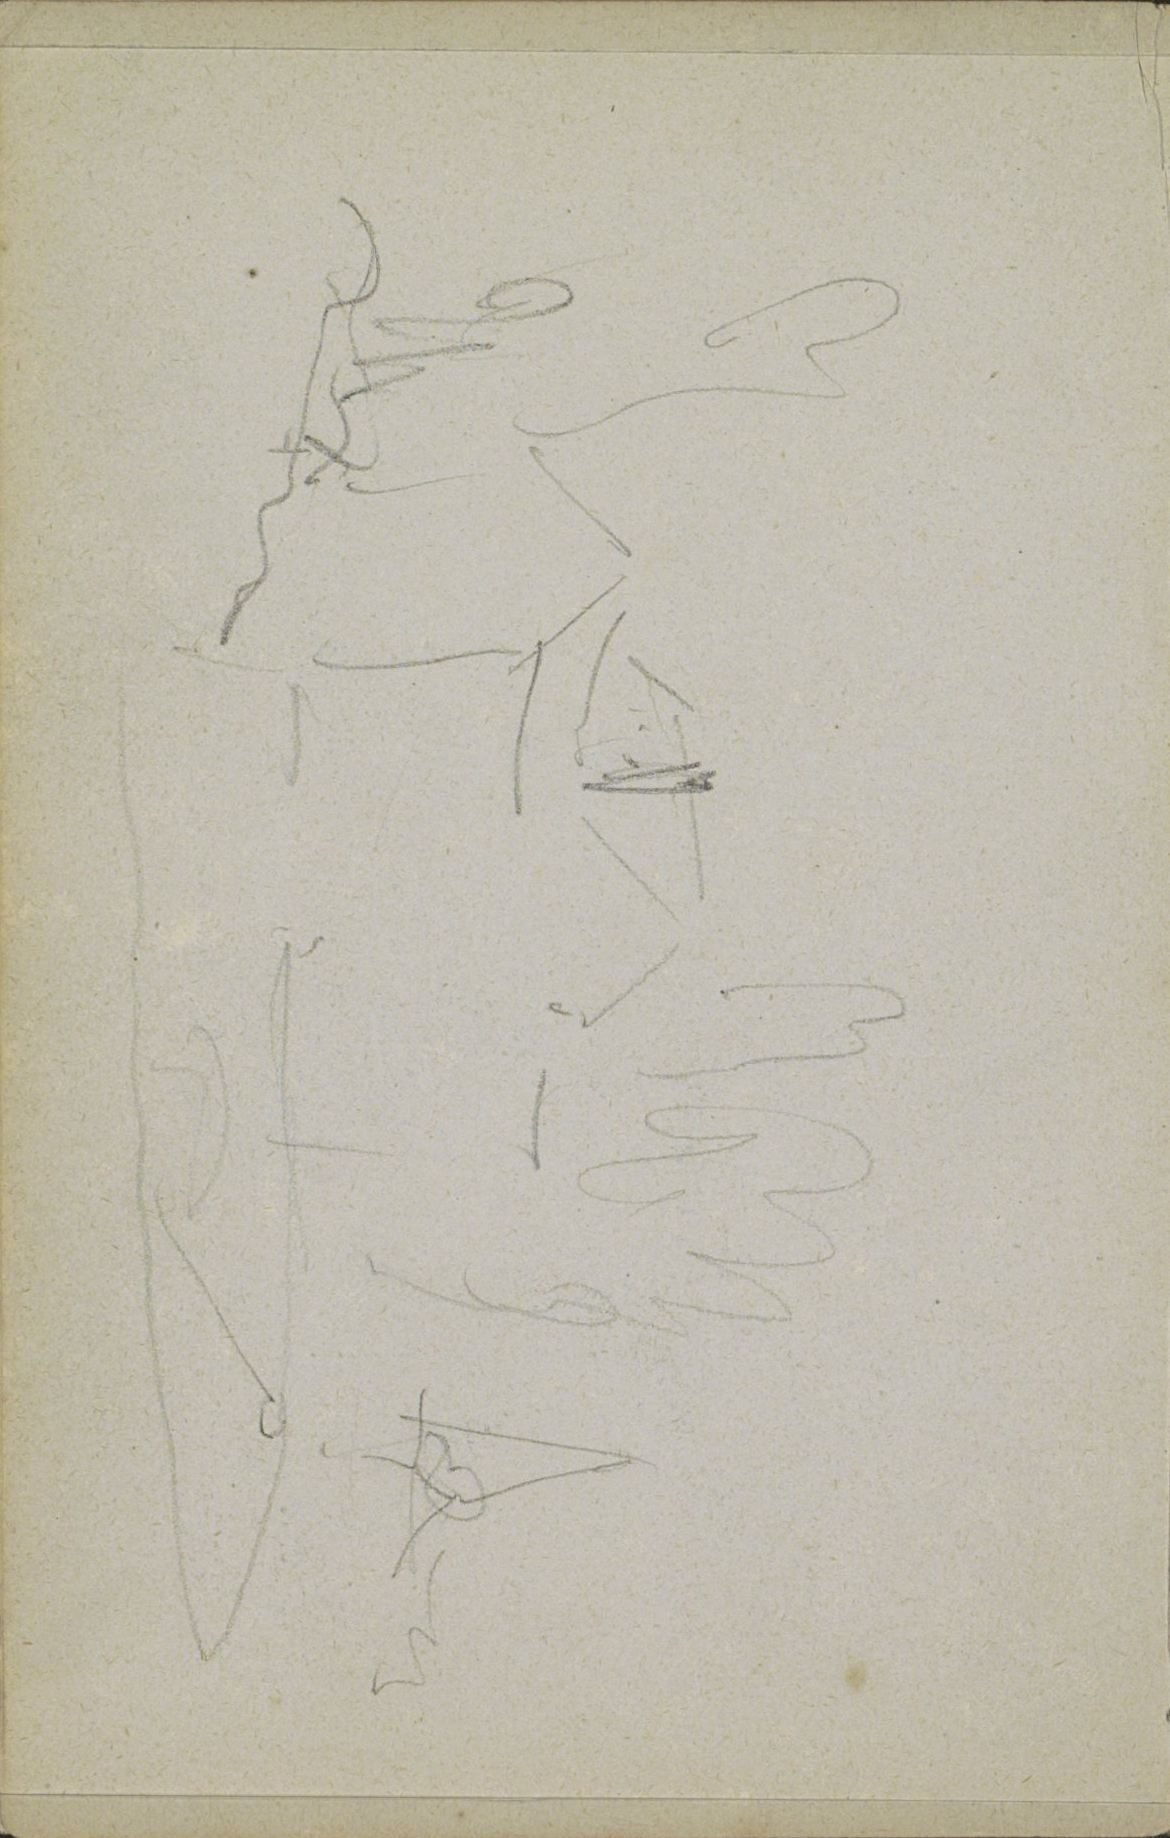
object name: sketchbook leaf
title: Gezicht op een gebouw tussen bomen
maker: adrianus eversen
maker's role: draughtsman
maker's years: 1818-1897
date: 1828-1897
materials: paper, pencil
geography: netherlands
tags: trees, civic architecture; edifices; dwellings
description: Gezicht op een gebouw tussen bomen. Rechts mogelijk een zeilschip. Blad 4 verso uit een schetsboek met 58 bladen.